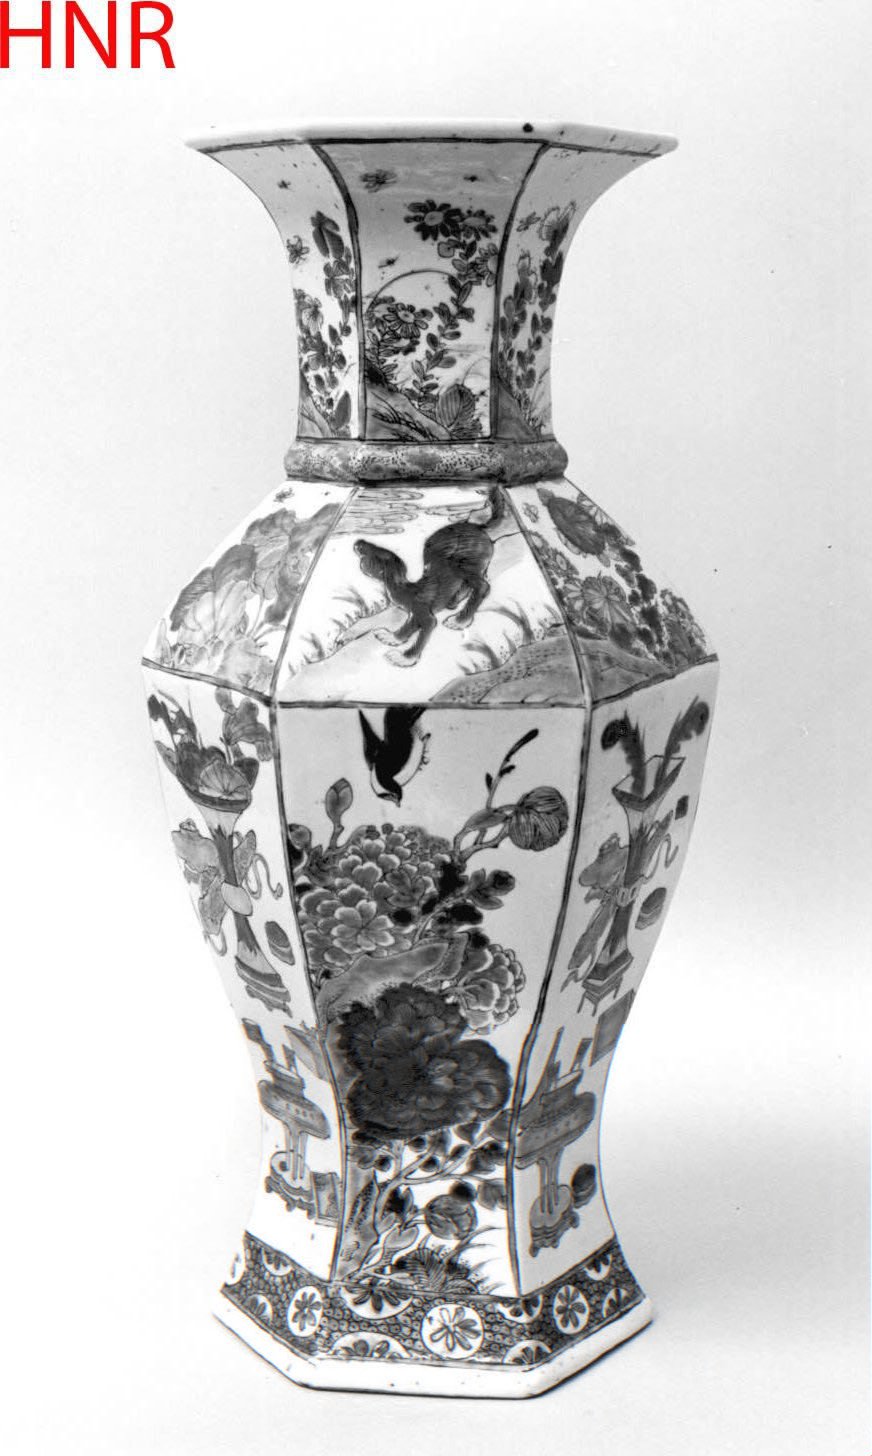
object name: vase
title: Hexagonal, baluster vase with flower sprays, antiquities and animals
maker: Anonymous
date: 1600-1900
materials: glaze, paint, porcelain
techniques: firing, forming, turning, vitrification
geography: china